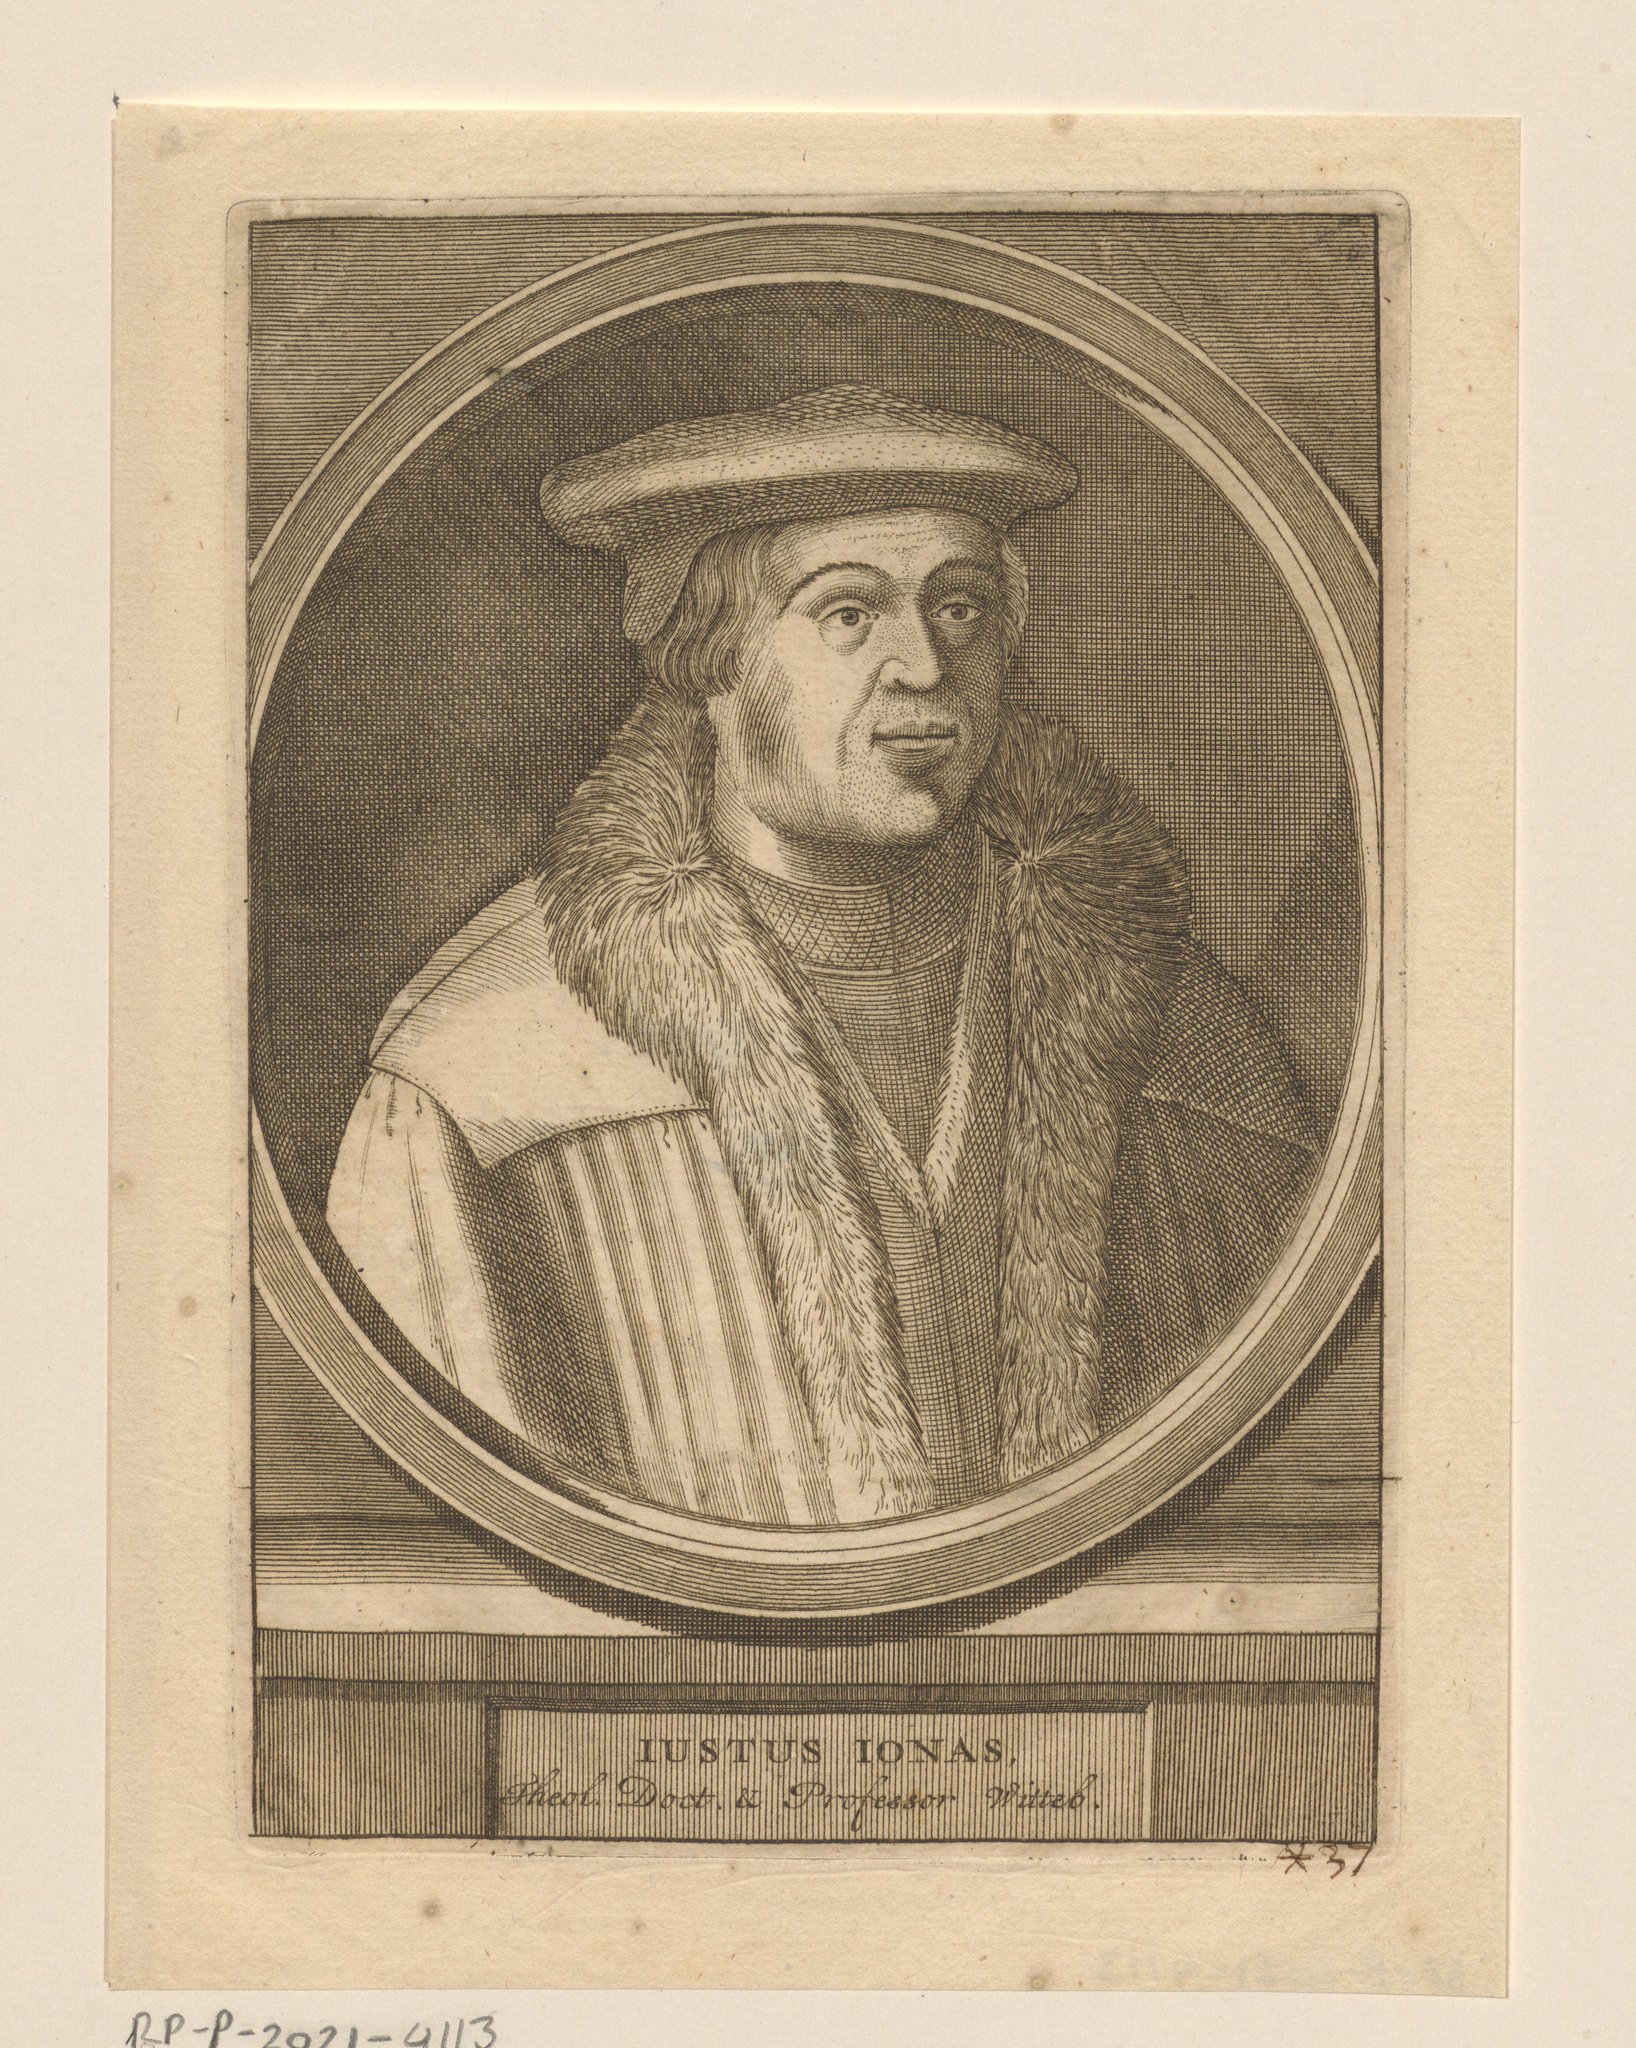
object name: print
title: Le miroir des portraits des premiers reformateurs des eglises protestantes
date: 1690-1729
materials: paper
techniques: engraving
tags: theologian, historical persons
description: Prent waarschijnlijk uit: Le miroir des portraits des premiers reformateurs des églises protestantes. Leiden: Pieter van der Aa, [1690-1729]. Eerdere staat gebruikt in serie uit 1599 en publicaties uit 1602 en 1604.